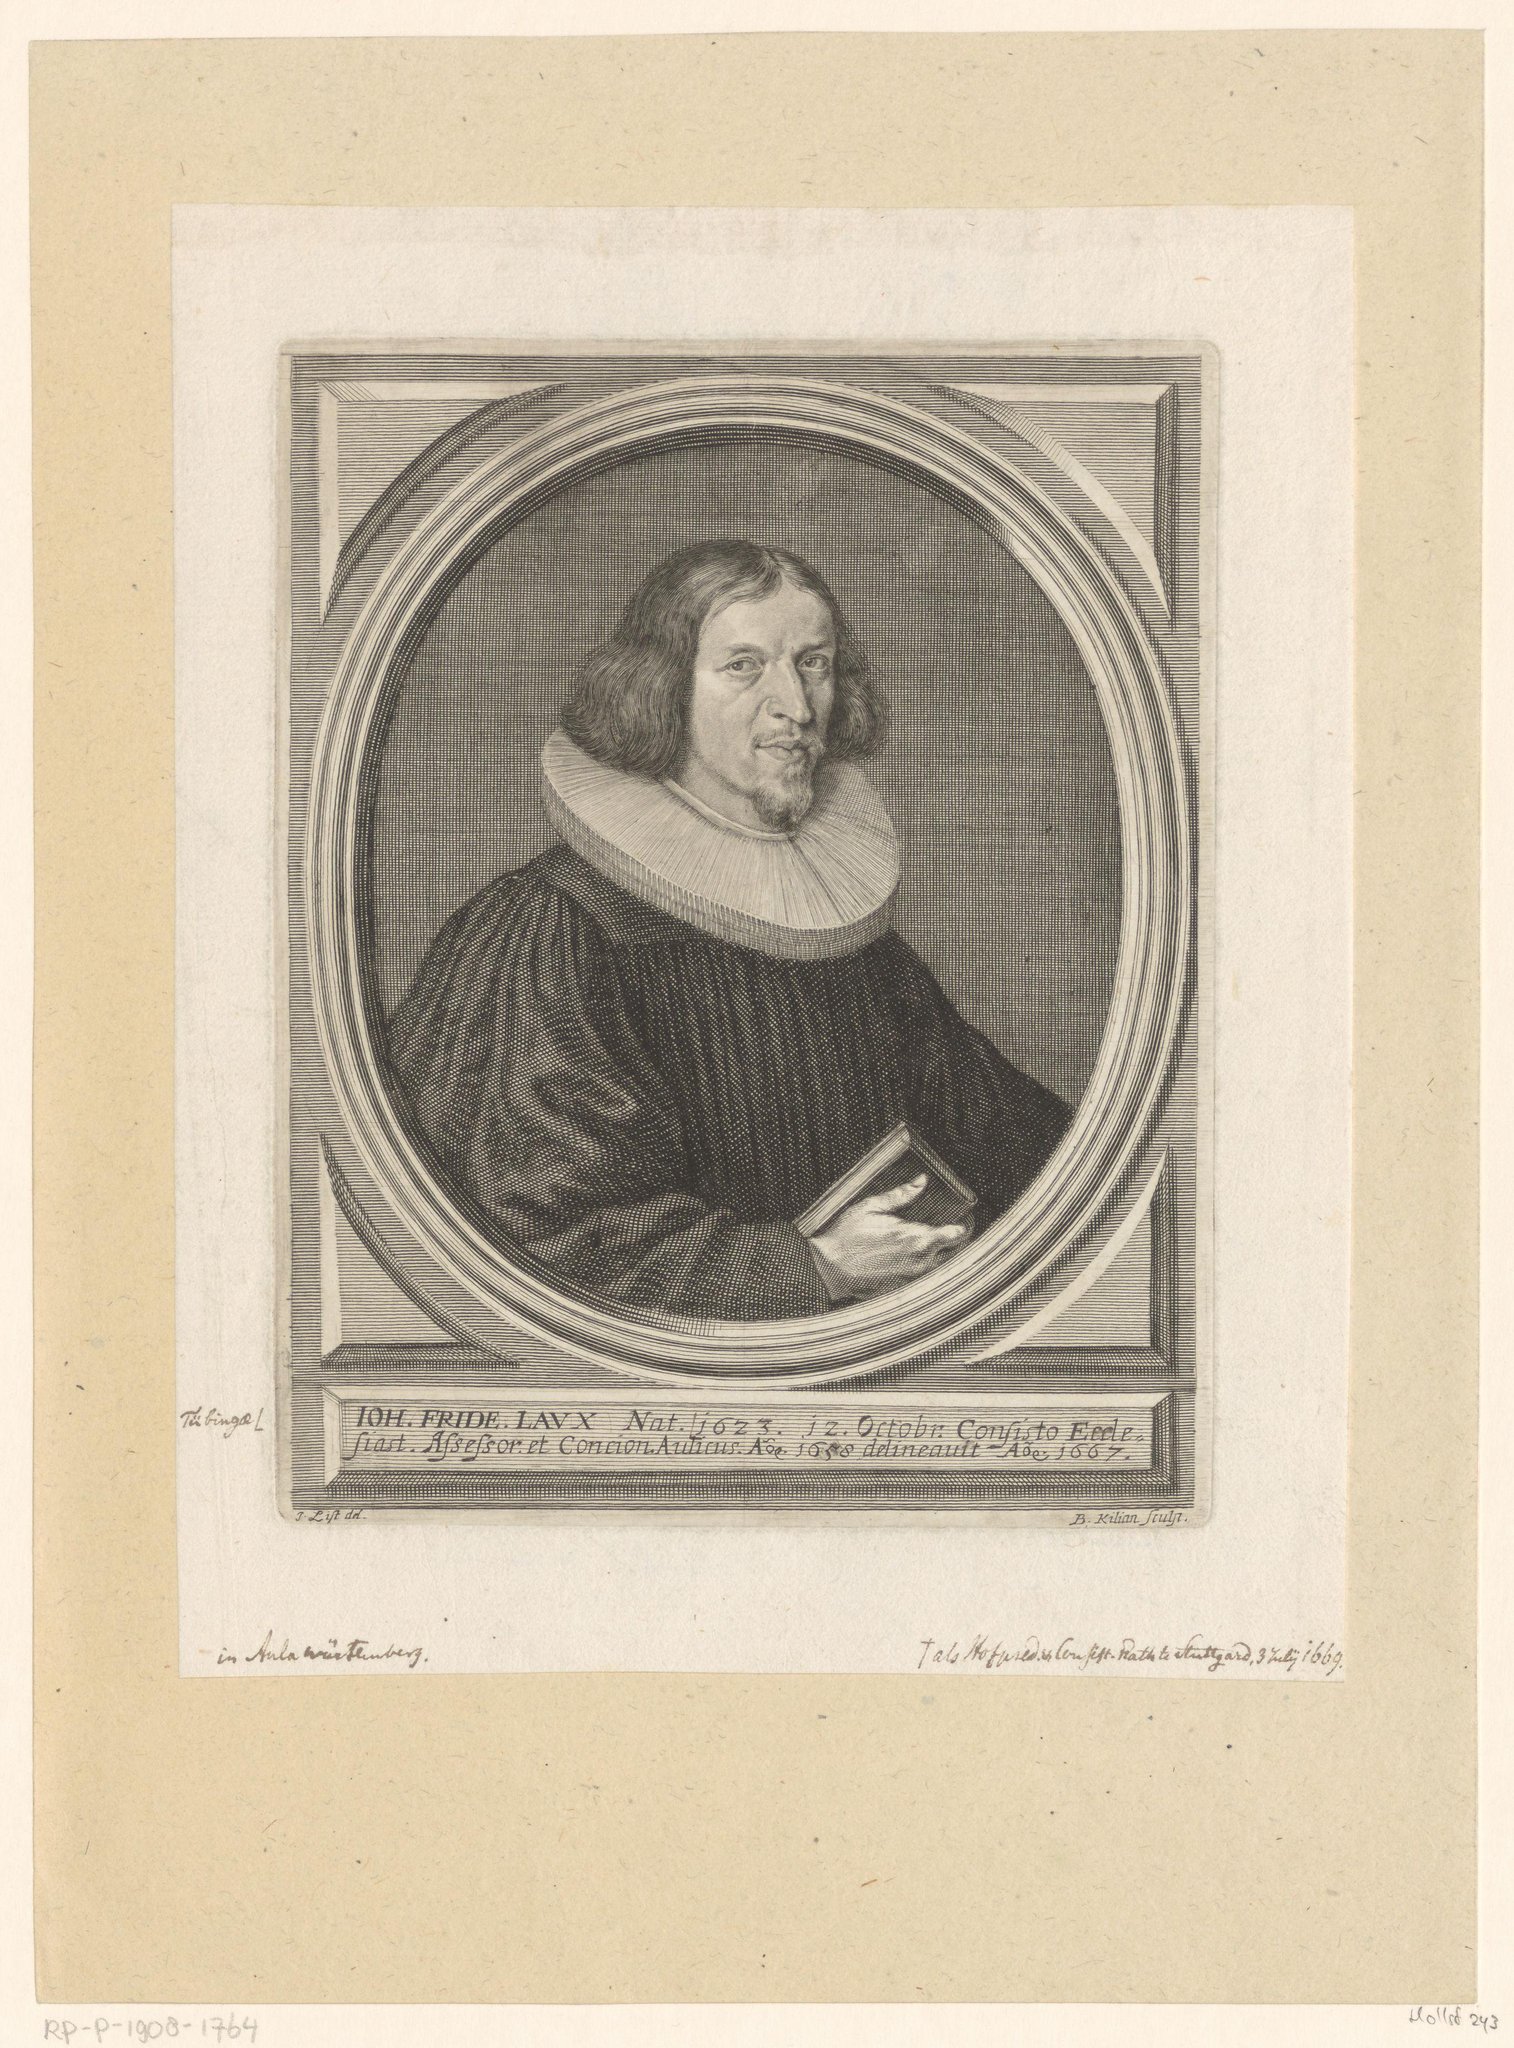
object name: print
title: Portret van Johann Friedrich Laux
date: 1667-1696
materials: paper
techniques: engraving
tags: theologian, historical persons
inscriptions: collector's mark: Lugt 2228